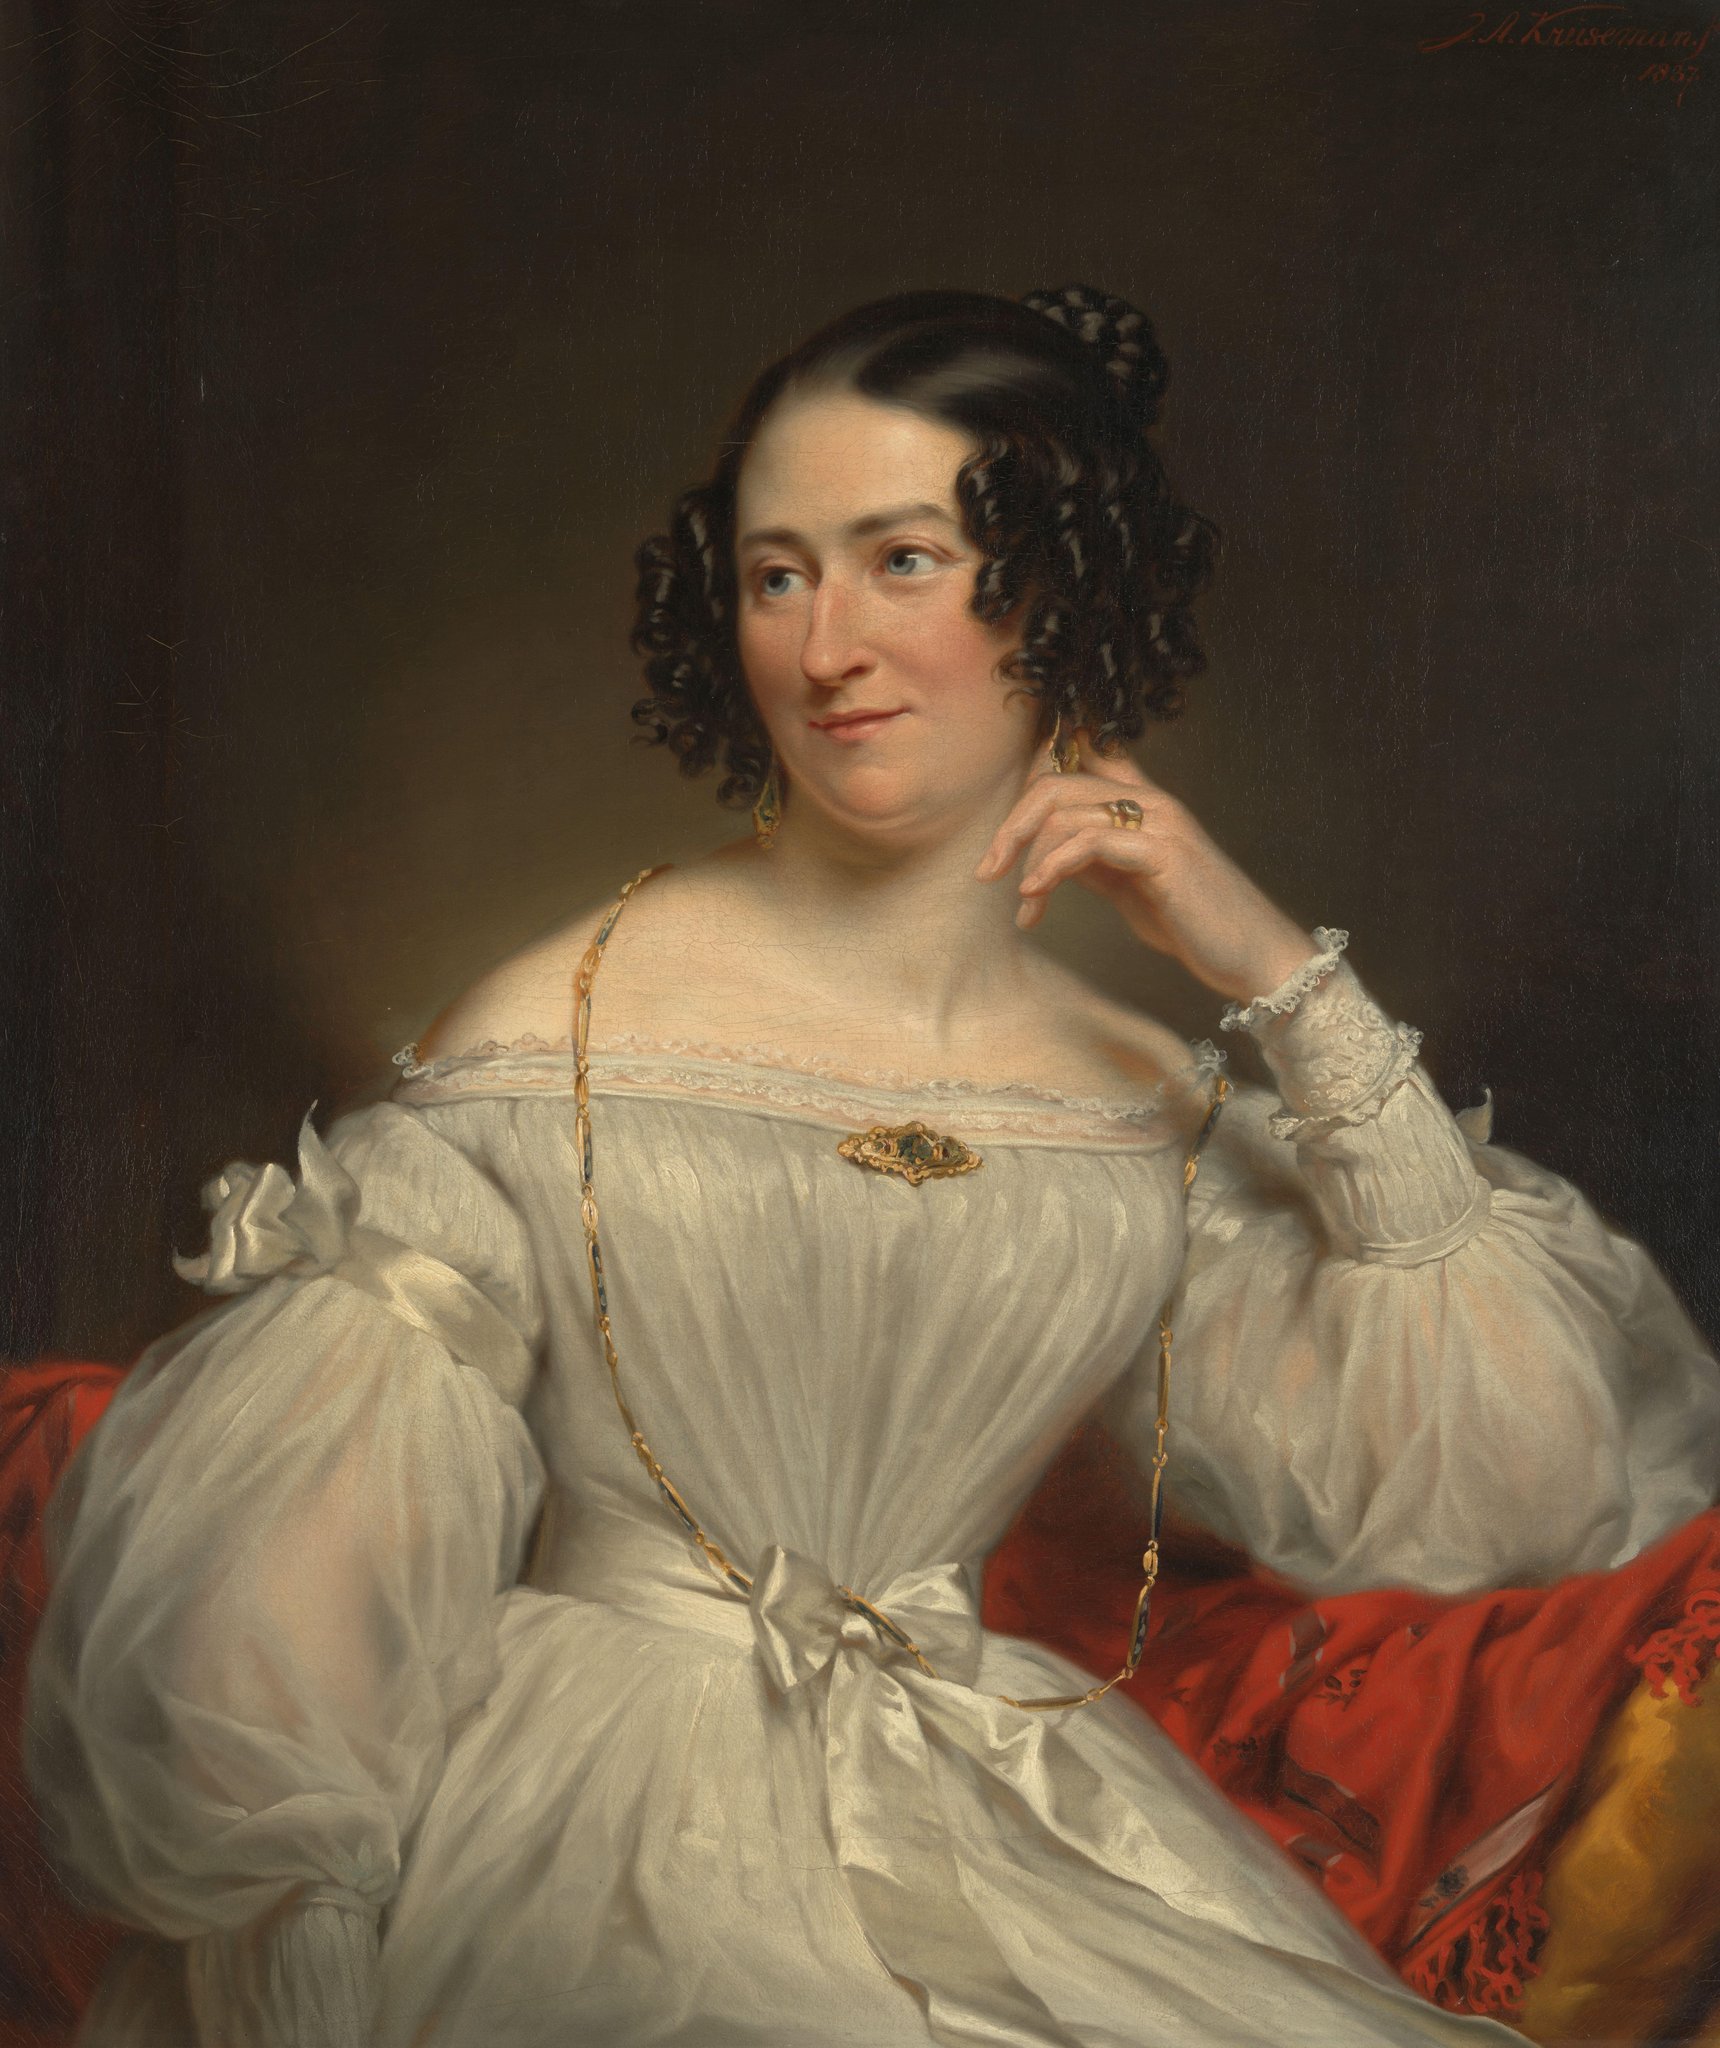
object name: painting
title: Portret van Abrahamina Henriëtte Wurfbain (1808-1883), echtgenote van Jacob de Vos Jz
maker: jan adam kruseman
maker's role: draughtsman, painter, print maker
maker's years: 1804-1862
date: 1837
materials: canvas, oil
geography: amsterdam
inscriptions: signature and date